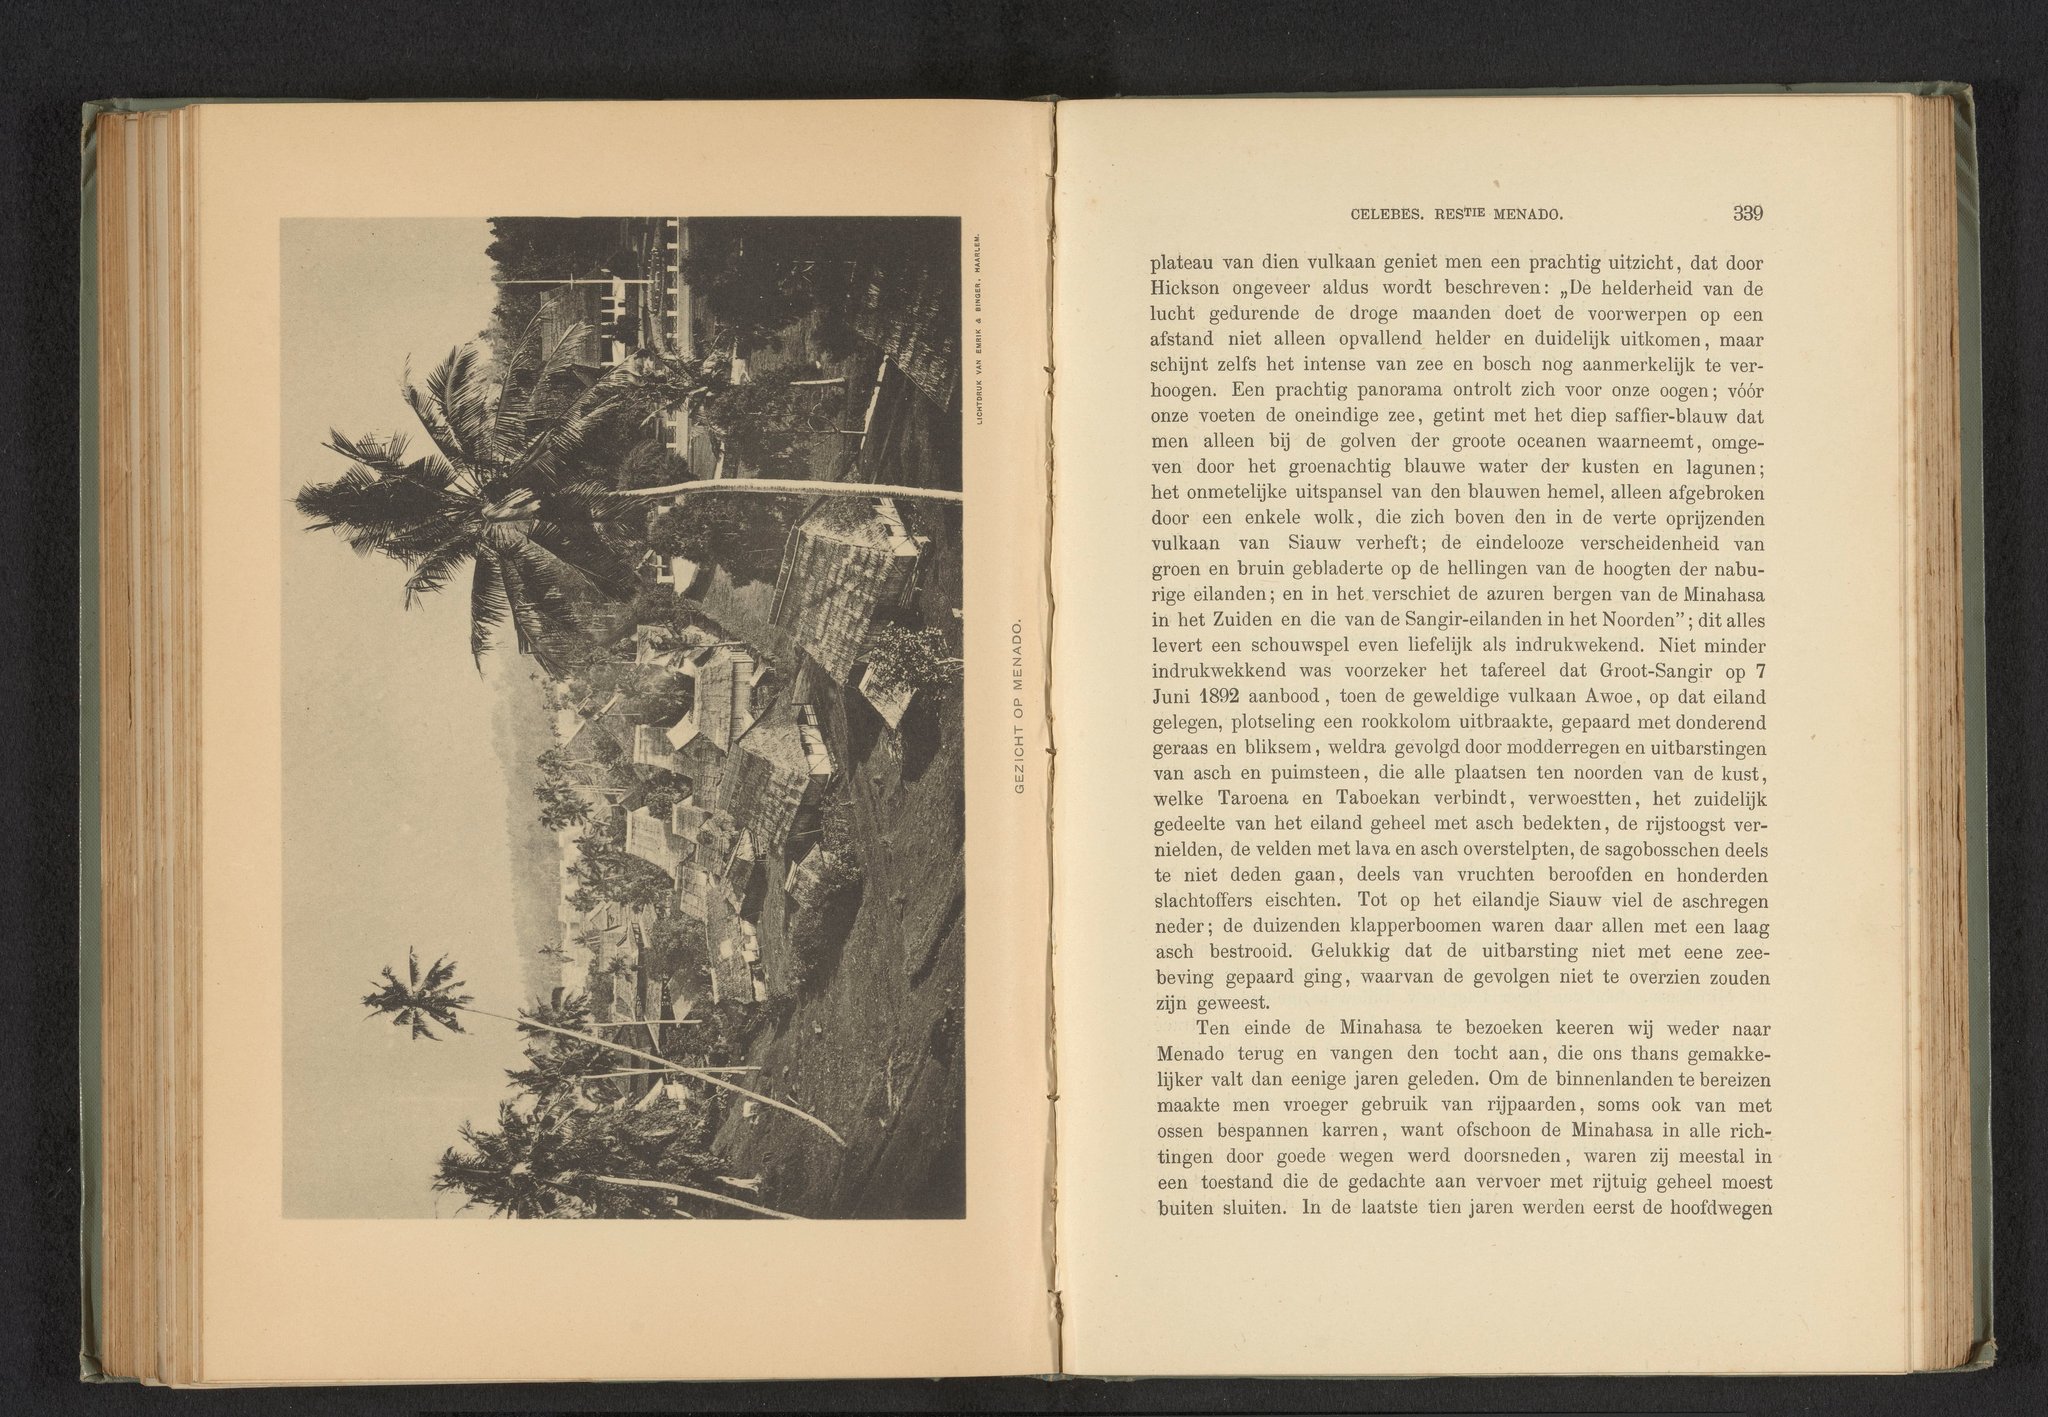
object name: photomechanical print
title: Gezicht op Menado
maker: Anonymous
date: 1883-1894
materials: paper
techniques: photograph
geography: manado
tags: city-view, and landscape with man-made constructions, housing, trees: palm-tree